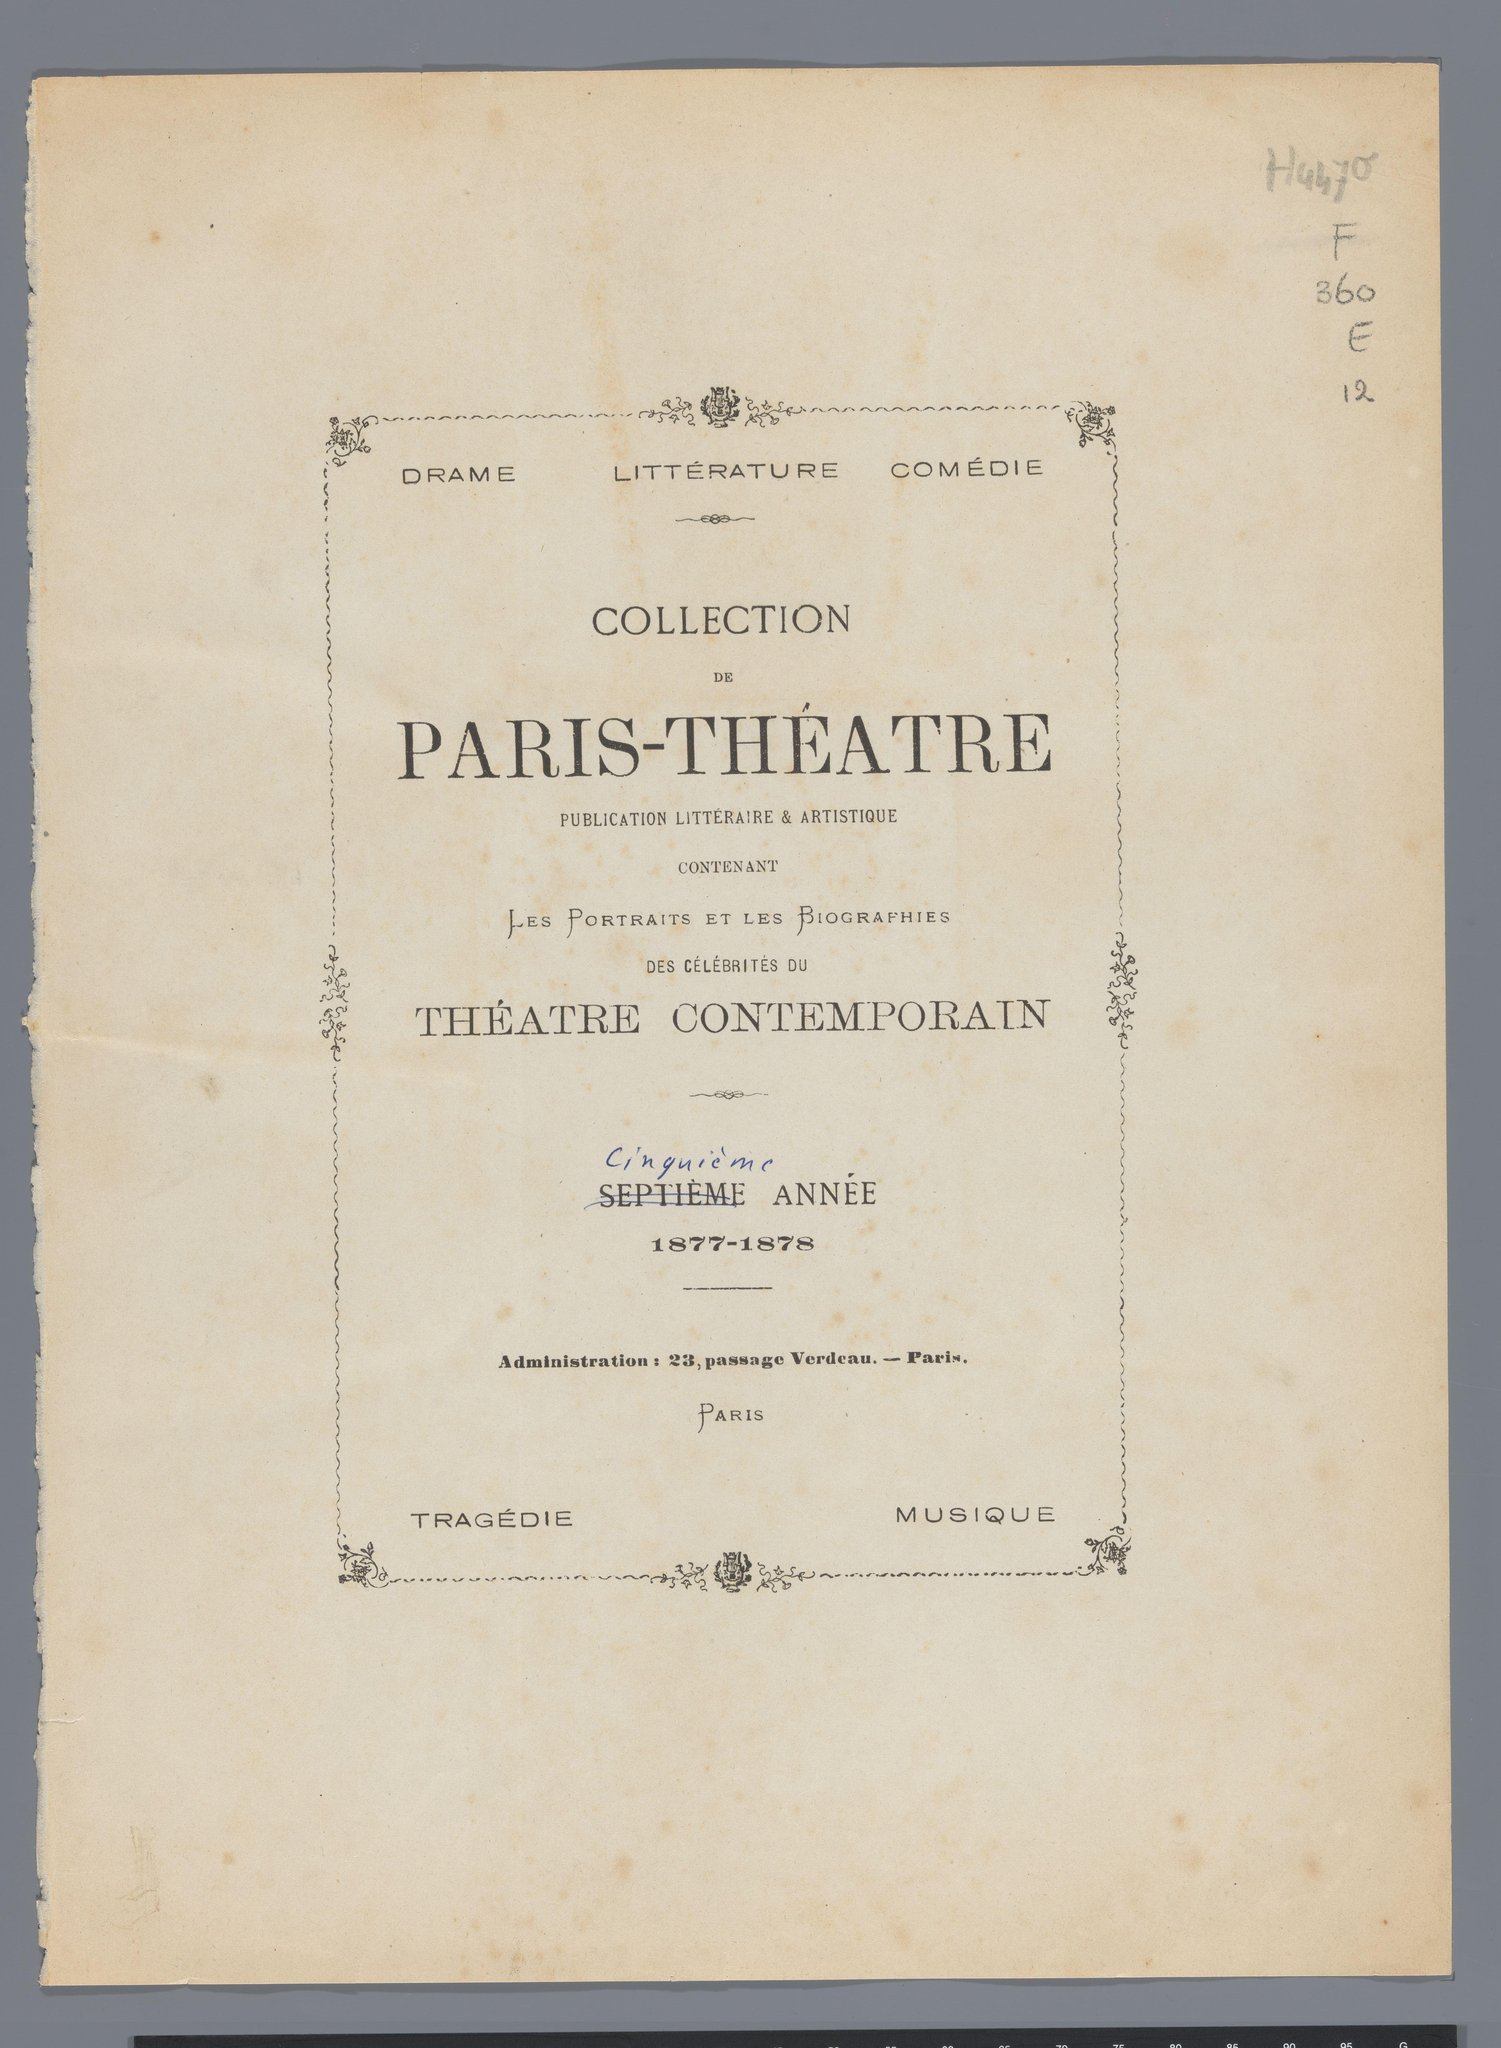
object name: wrapper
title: Paris-Portrait: ancien Paris-Theatre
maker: eugène paz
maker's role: journalist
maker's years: 1835-1901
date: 1872-1879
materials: cardboard, paper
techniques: printing, woodburytype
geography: paris